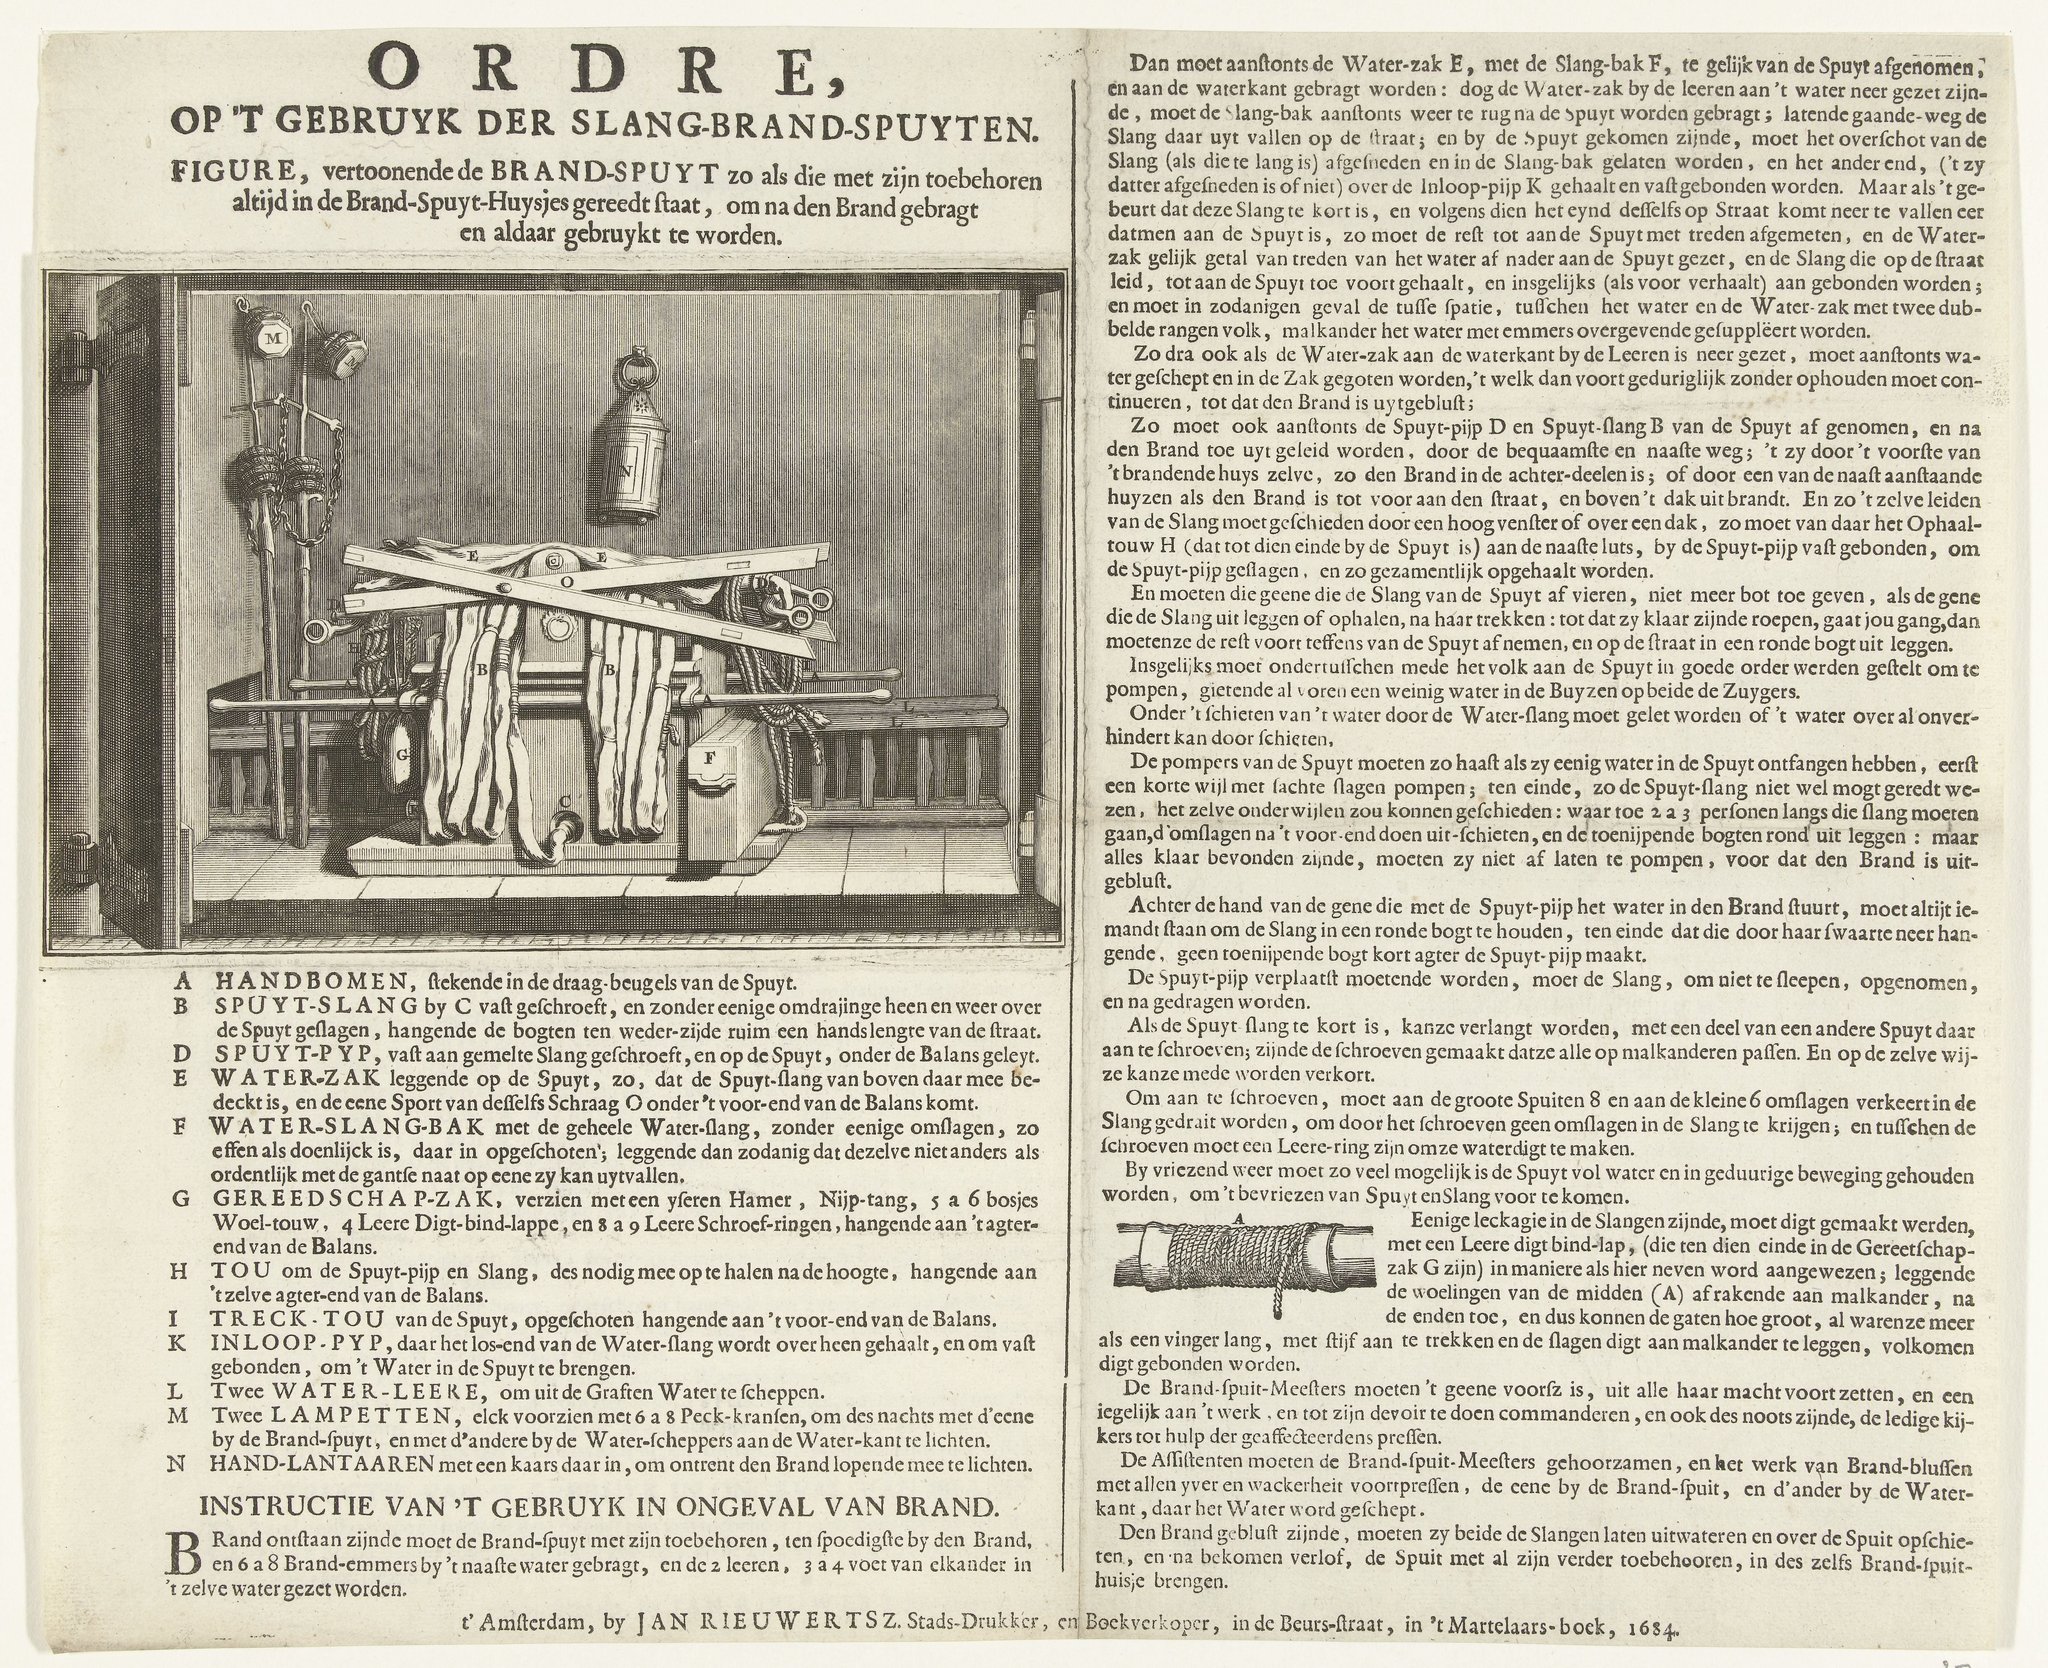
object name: print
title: Ordre, op 't gebruyk der Slang-brand-spuyten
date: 1684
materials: paper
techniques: etching, letterpress printing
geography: amsterdam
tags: amsterdam, painter, print maker, draughtsman, jan van der heyden, fire-extinguishing equipment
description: Blad met een instructie over het correcte gebruik en bewaring van de slangbrandspuiten, 1684. Links een voorstelling hoe de slangbrandspuit en pomp in het brandspuithuisje opgeborgen dienen te worden na gebruik, met de legenda A-N. Onder en rechts de instructie voor gebruik in het geval van brand en een plaatje hoe een lekkage in een slang gerepareerd dient te worden. Behoort tot de bijprenten bij het Brandspuitenboek van Jan van der Heyden.